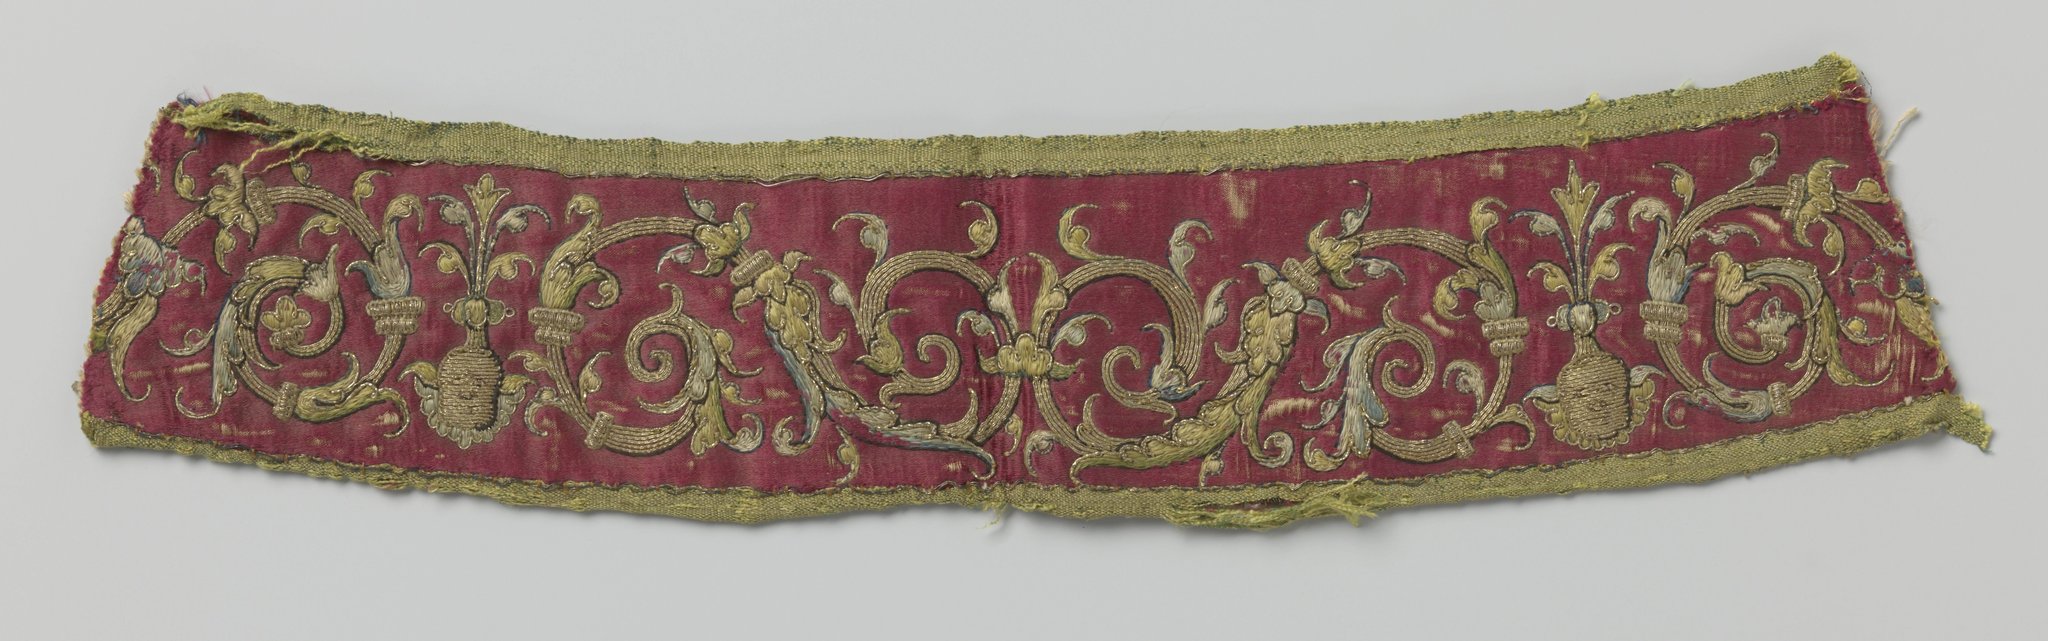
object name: embroidery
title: Fragment van een borduursel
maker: Anonymous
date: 1500-1600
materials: gold thread, linen, textile, silk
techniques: embroidered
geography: italy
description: Fragment van een geborduurde praetexta of aurifries van een dalmatiek. Het fragment bestaat uit rood satijn op een linnen voering. Het borduurwerk heeft rinceaux van goud en zijde in de kleuren geel en groen. Het fragment hoort bij twee fragmenten met invnrs. BK-NM-1239-B-2 en BK-NM-1239-B-3.